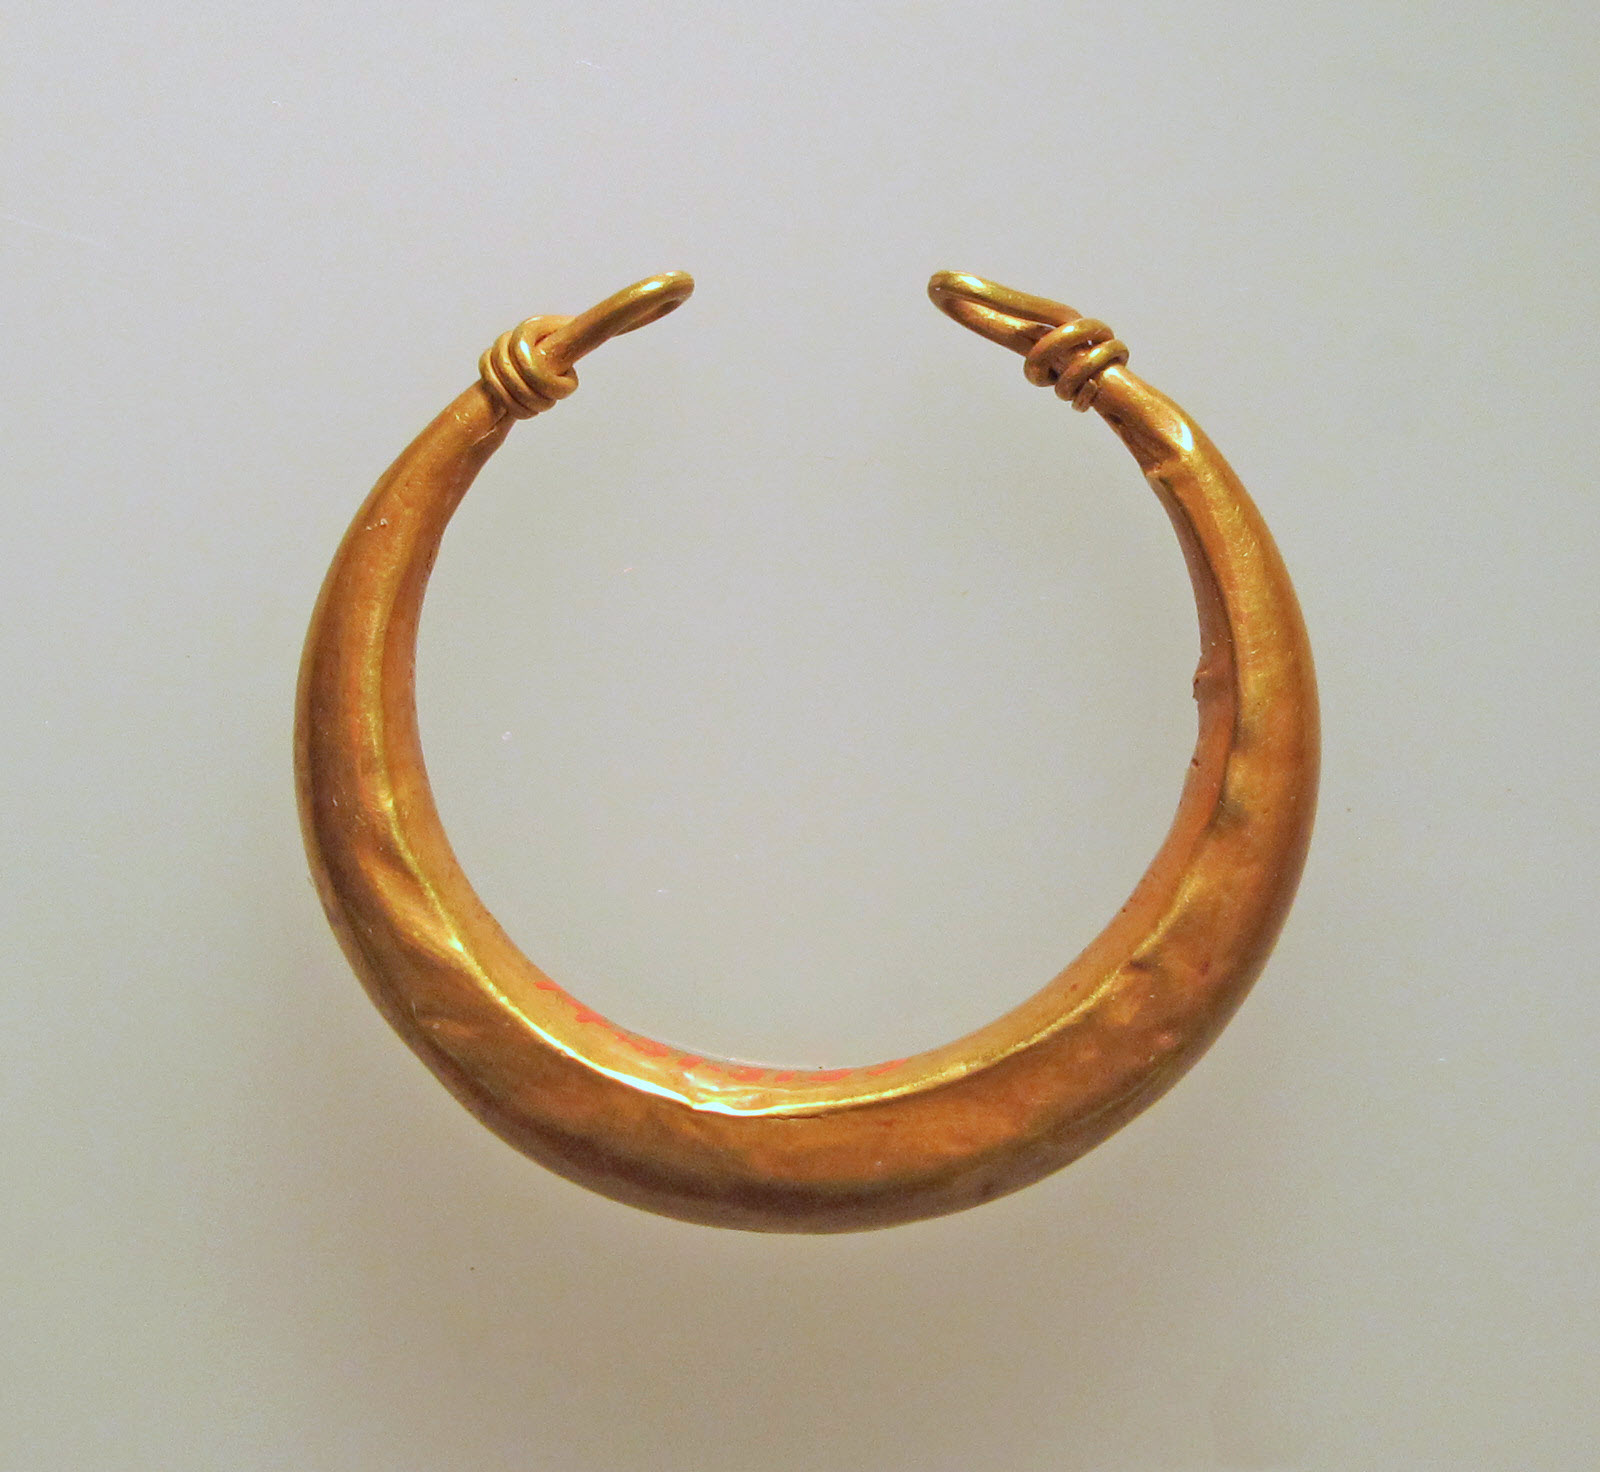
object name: earring of simple form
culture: cypriot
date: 3900 BCE-100 CE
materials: gold